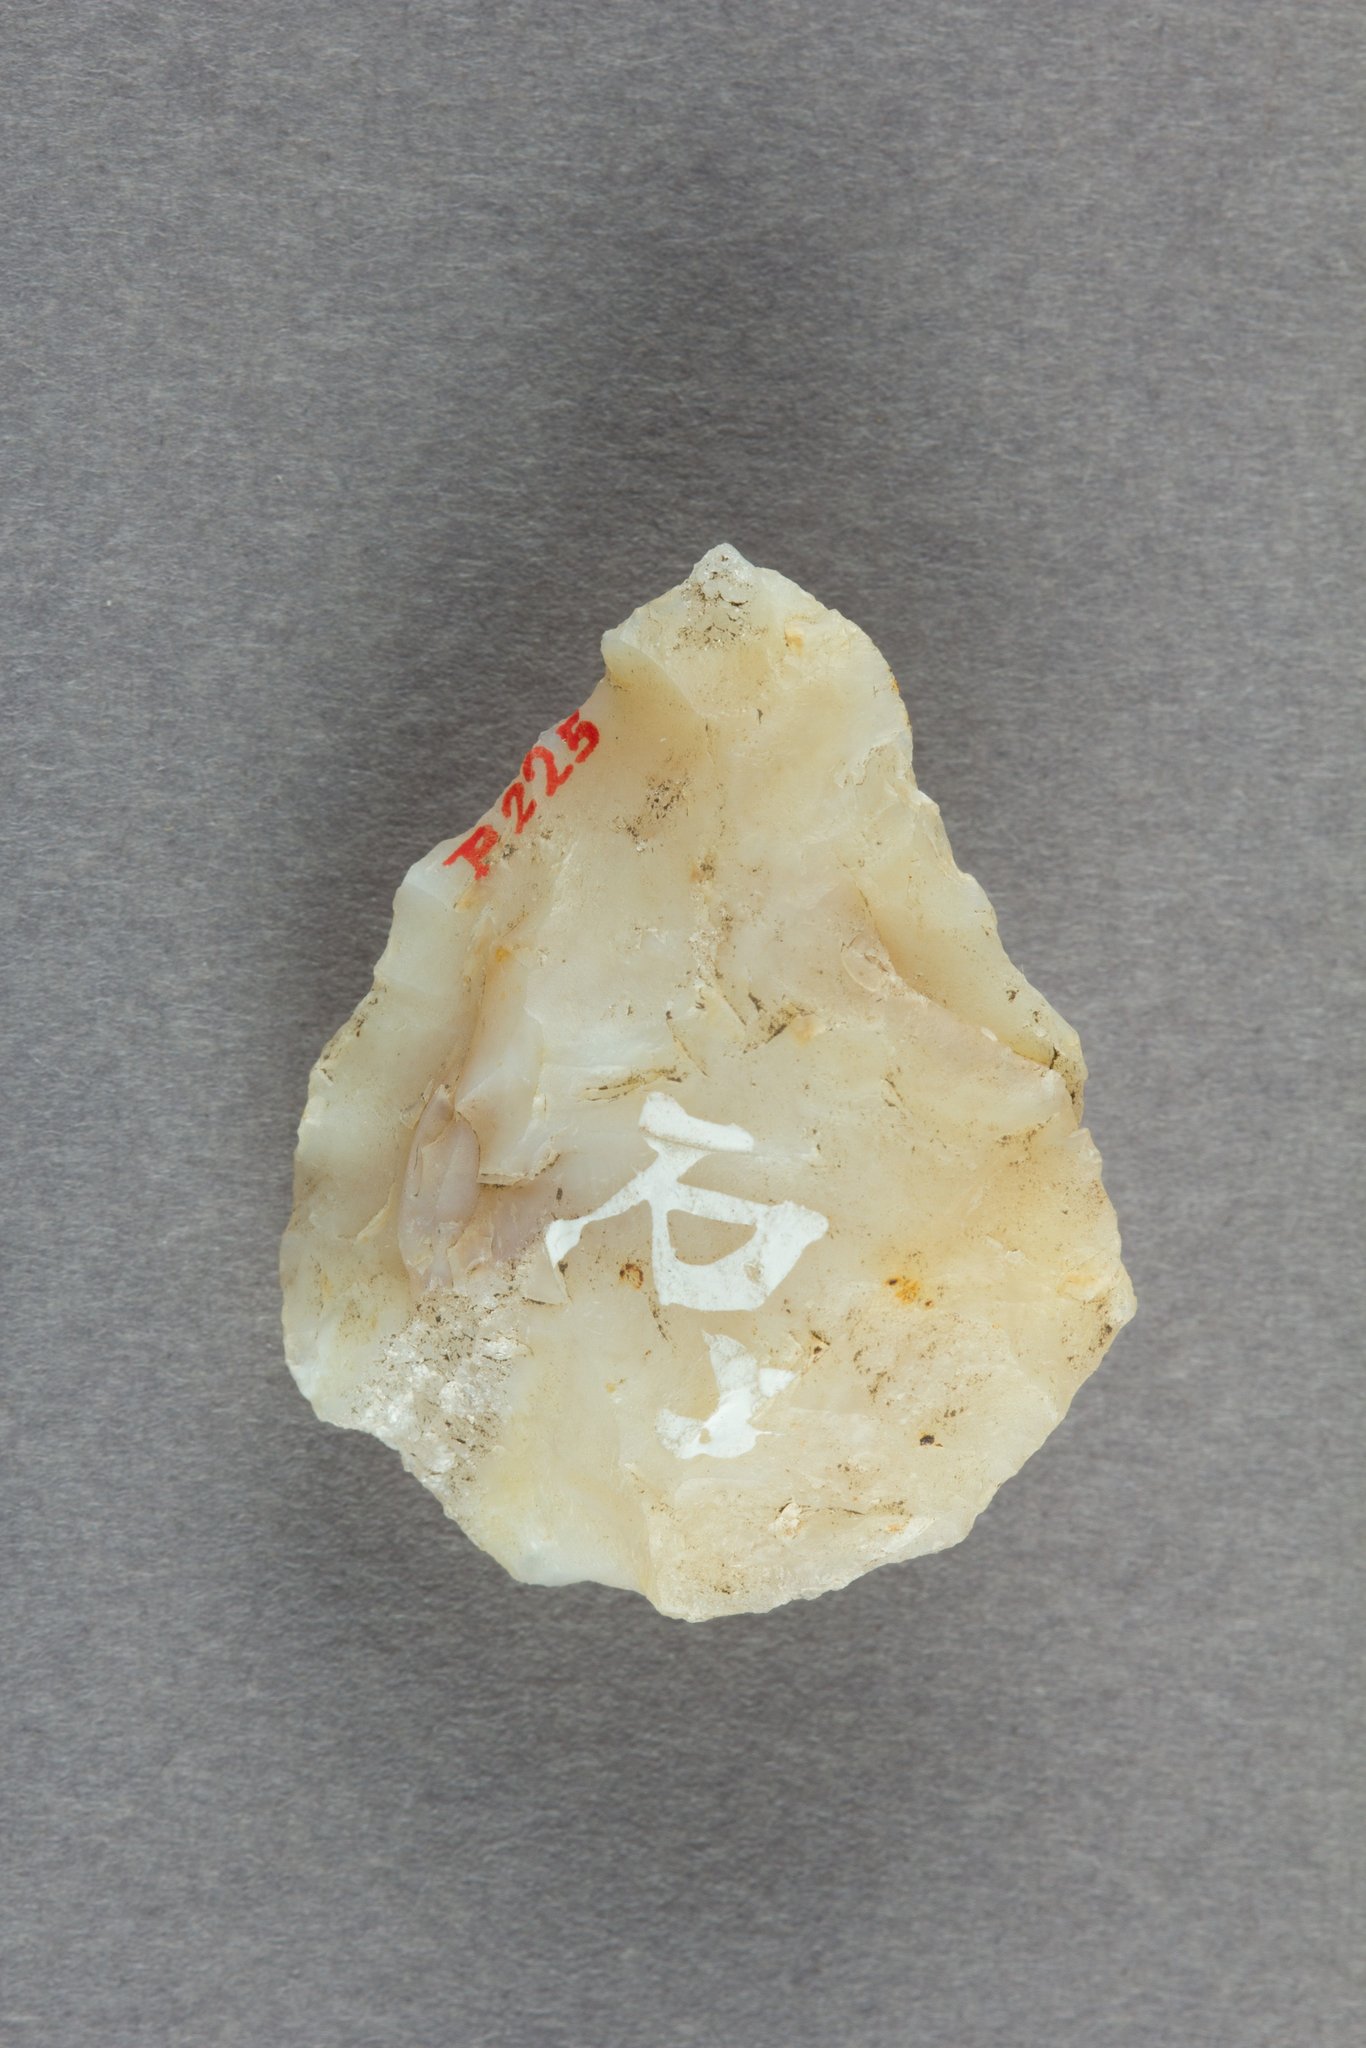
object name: arrowhead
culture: japanese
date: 1500-1000 BCE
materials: stone